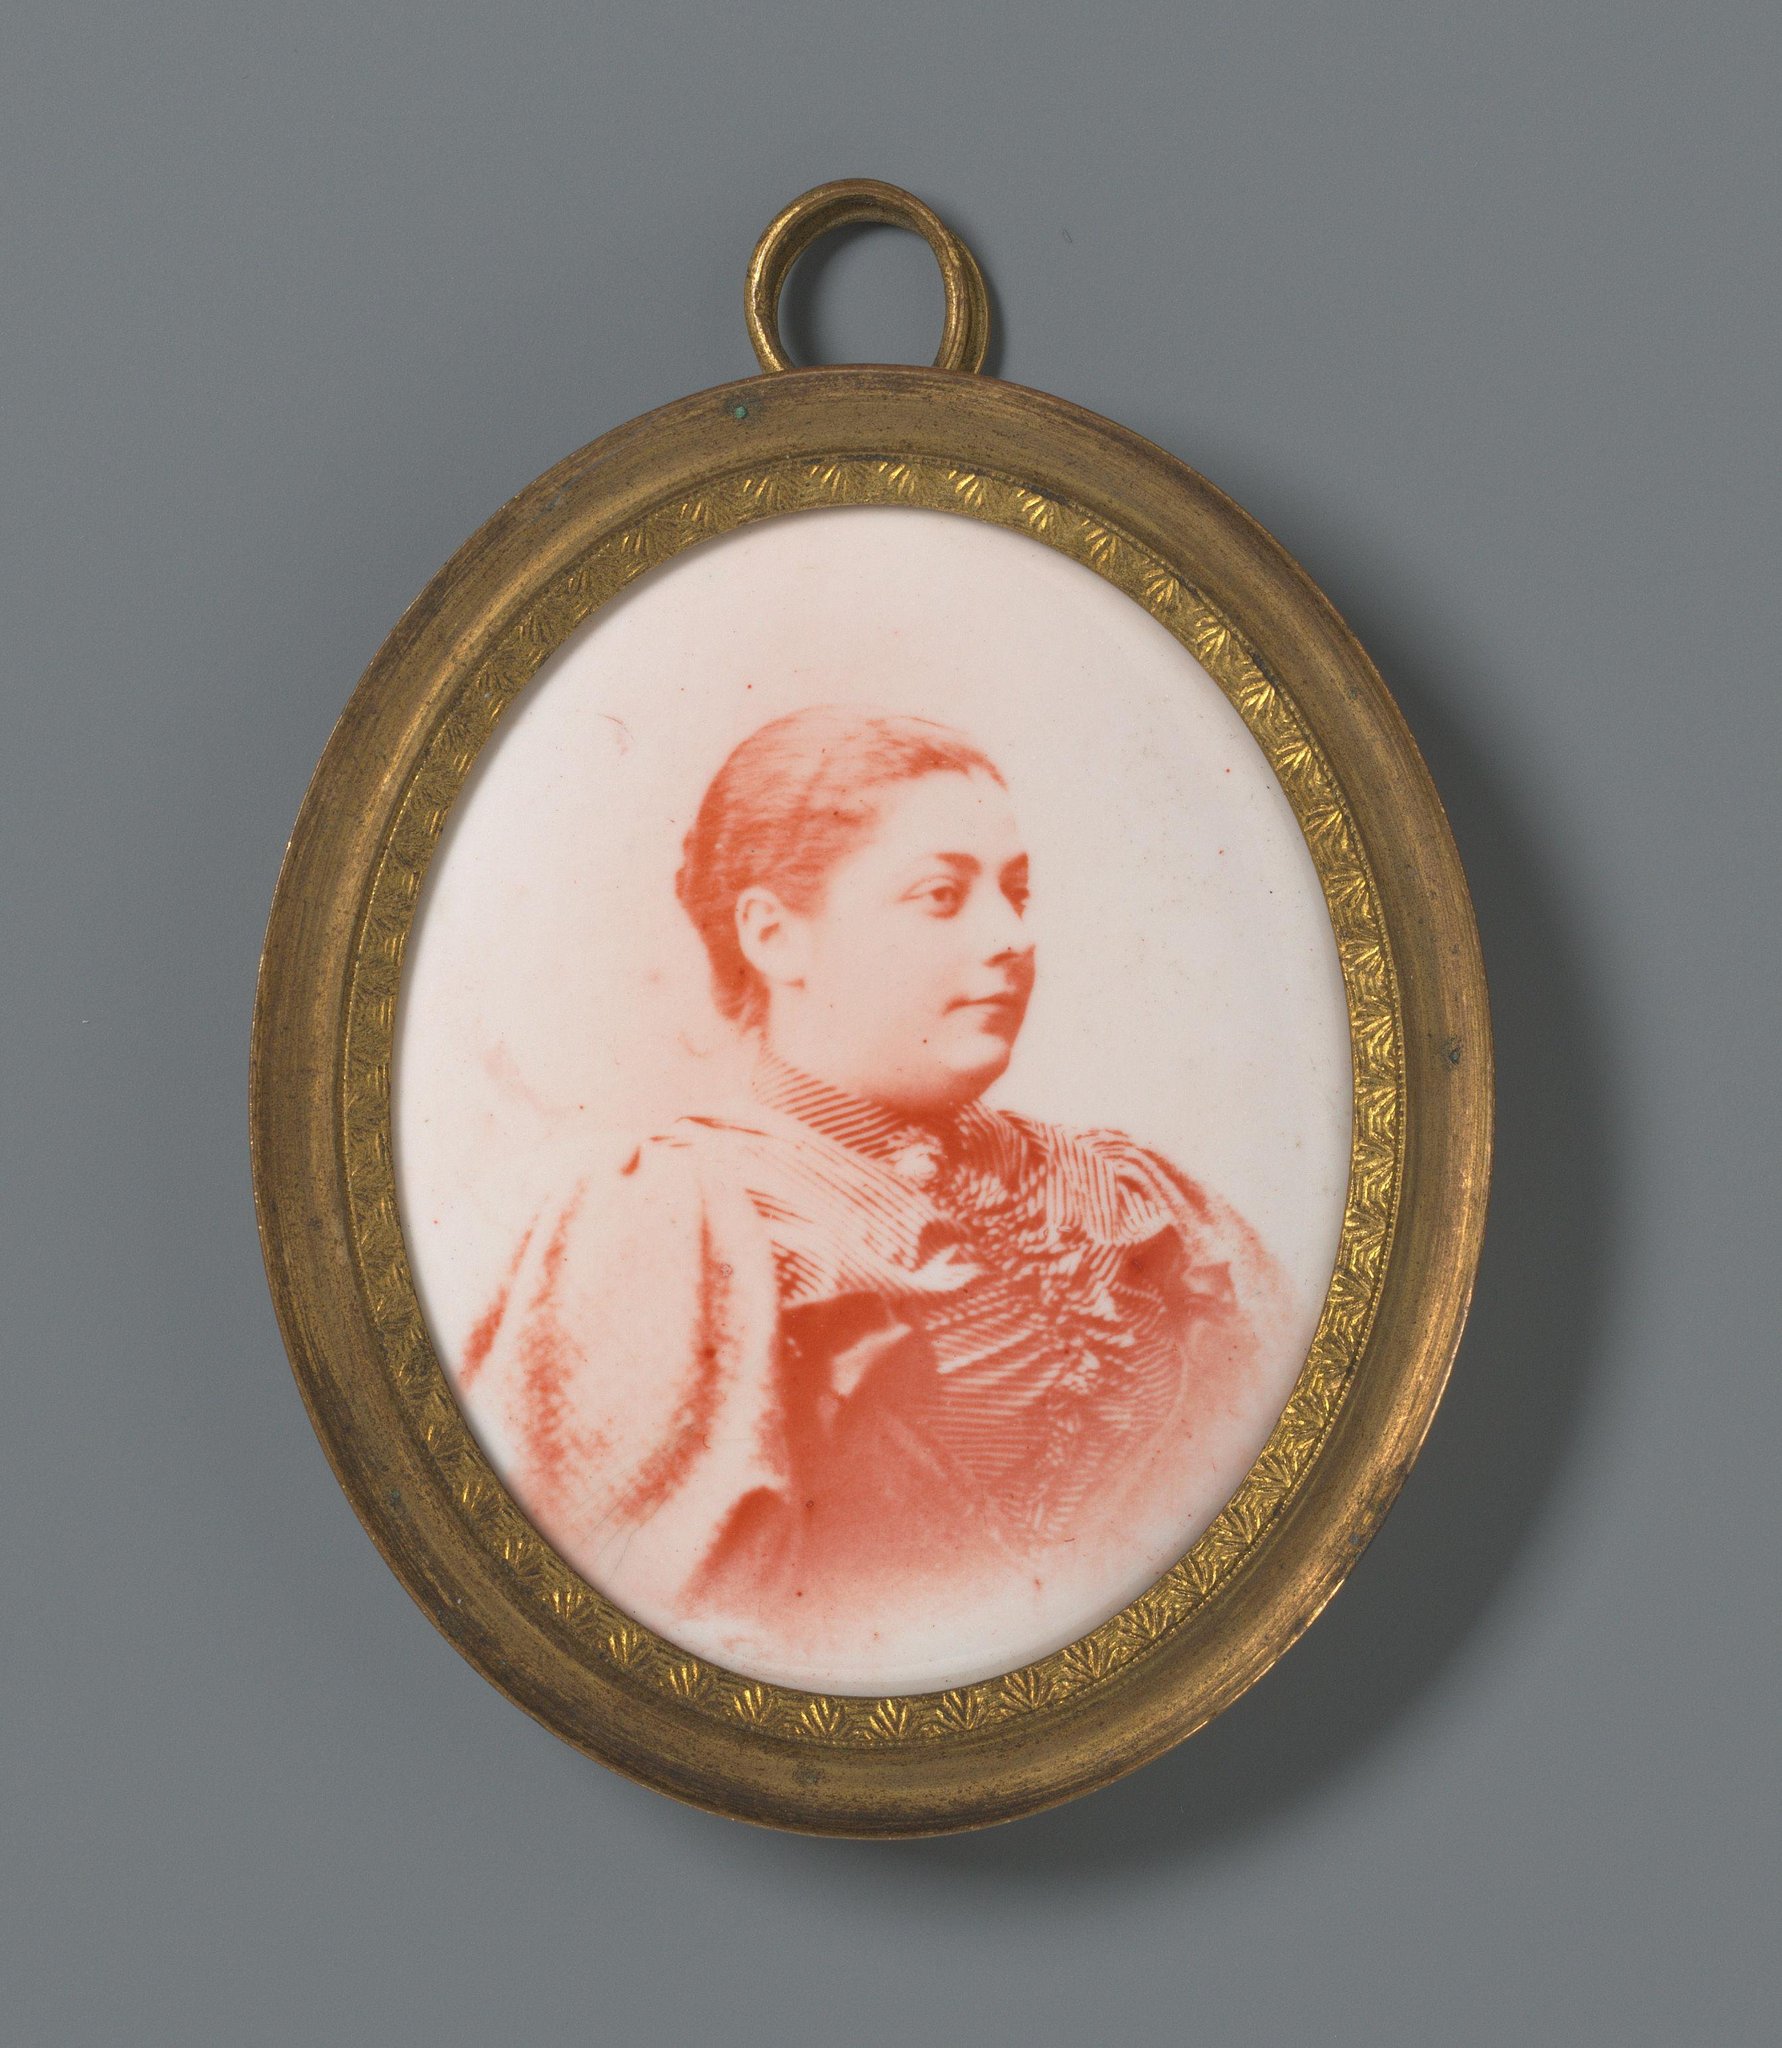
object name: locket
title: Portret van een onbekende vrouw in hanger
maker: Anonymous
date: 1885-1900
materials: cardboard, metal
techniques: enamel photograph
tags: adult woman, anonymous historical person portrayed